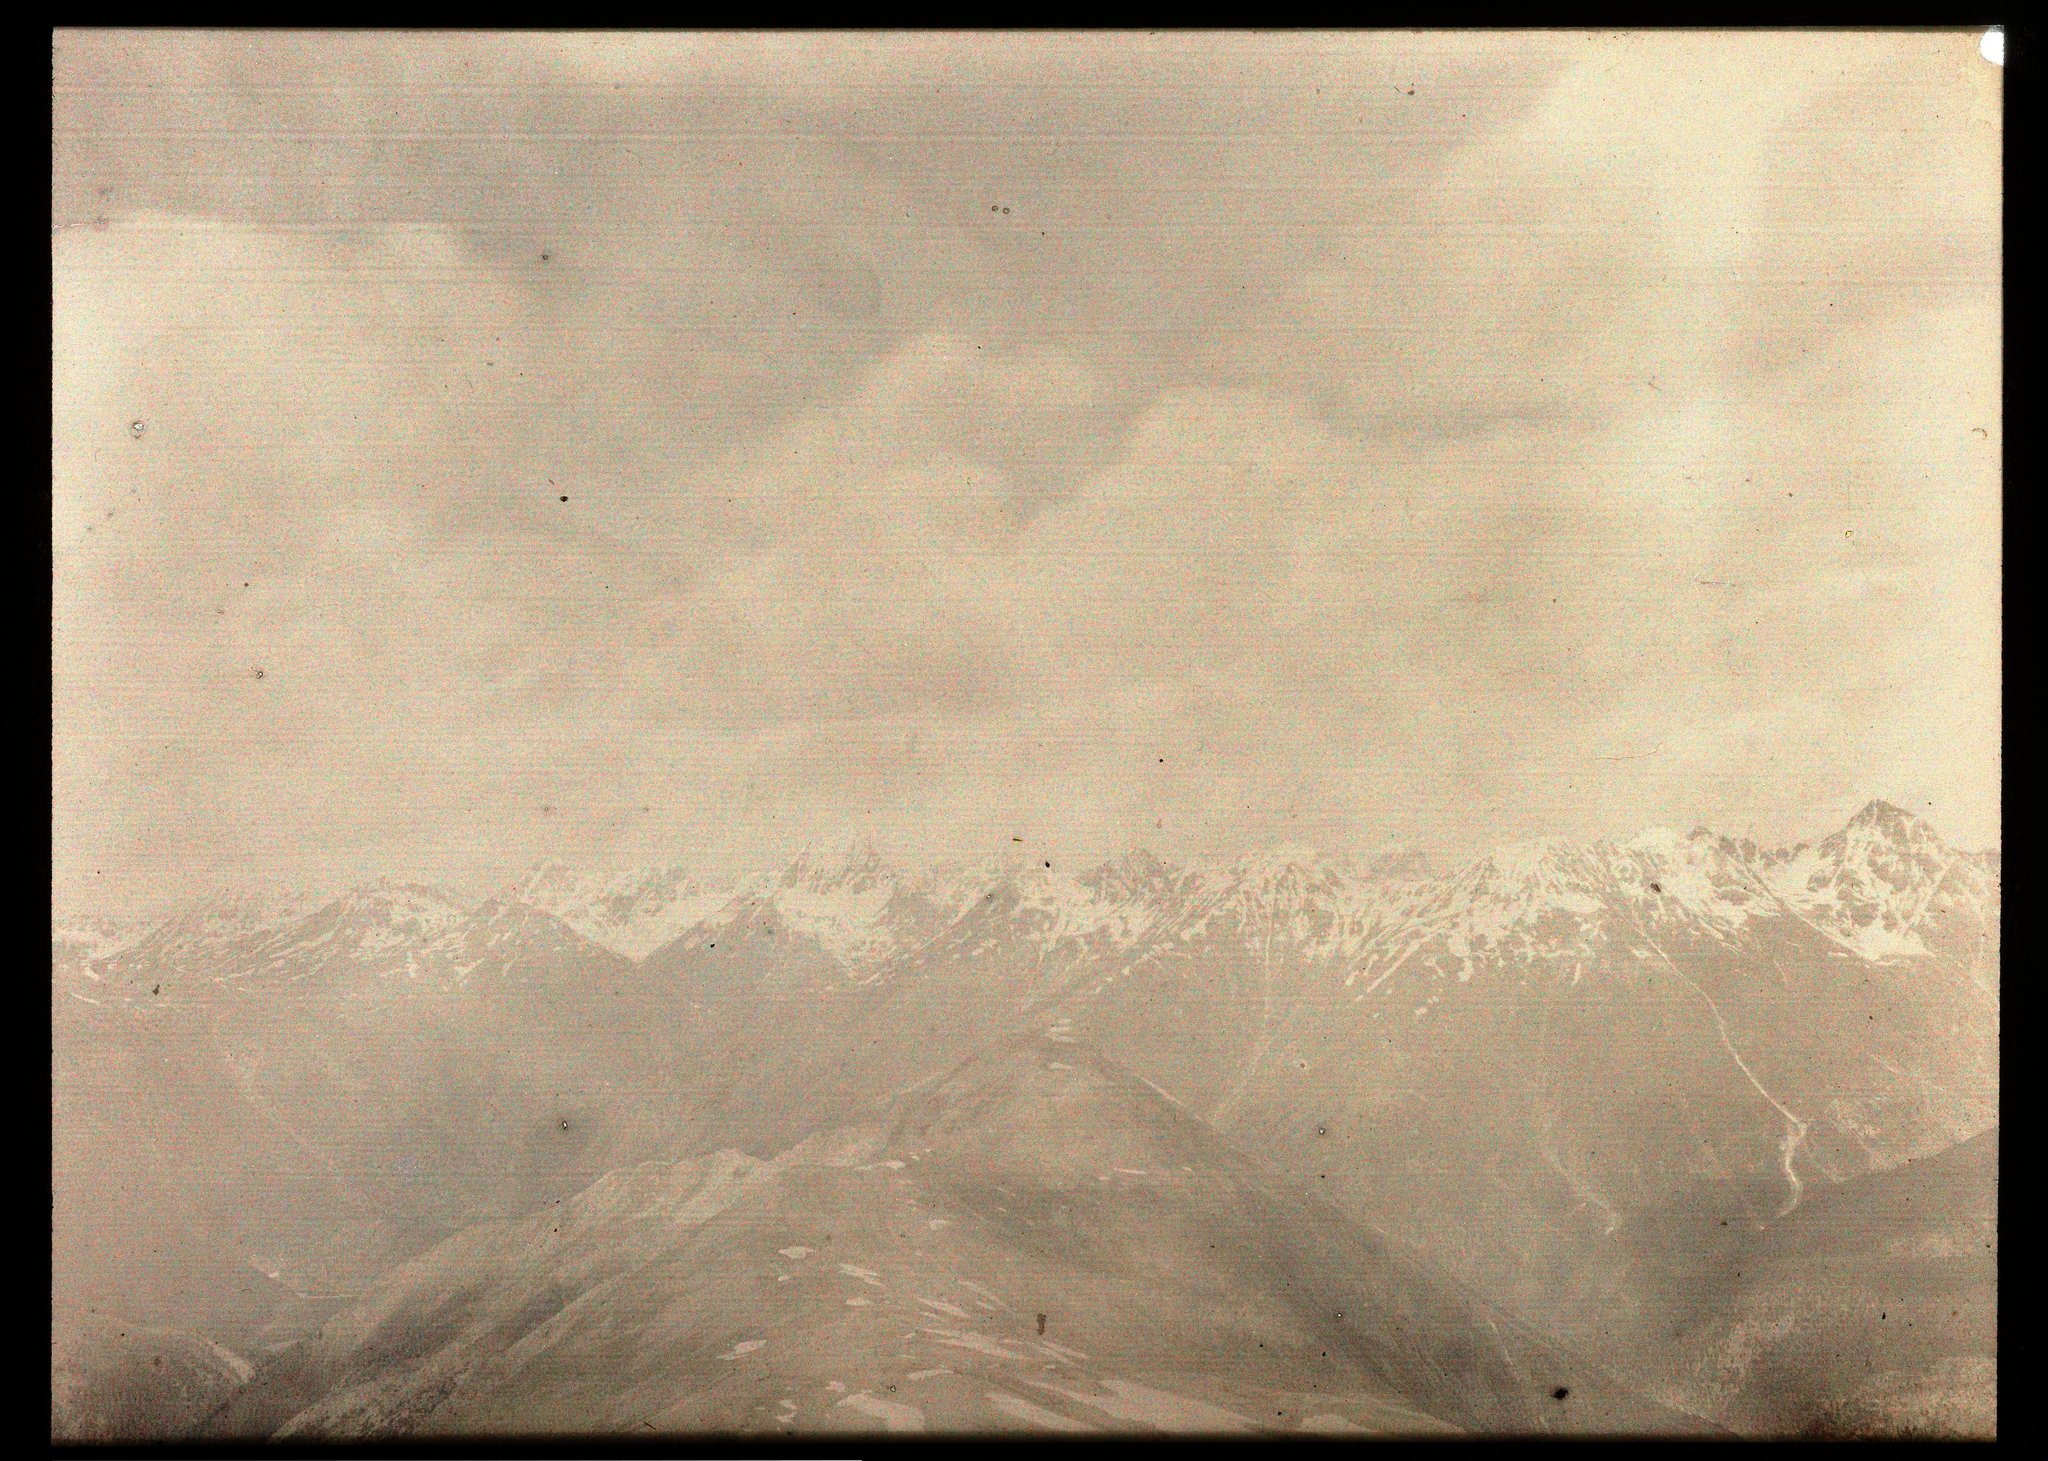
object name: color slide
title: Gezicht op besneeuwde bergtoppen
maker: adolphe burdet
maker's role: fotograaf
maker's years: 1860-1940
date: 1907-1930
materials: glass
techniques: autochrome process, slide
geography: netherlands